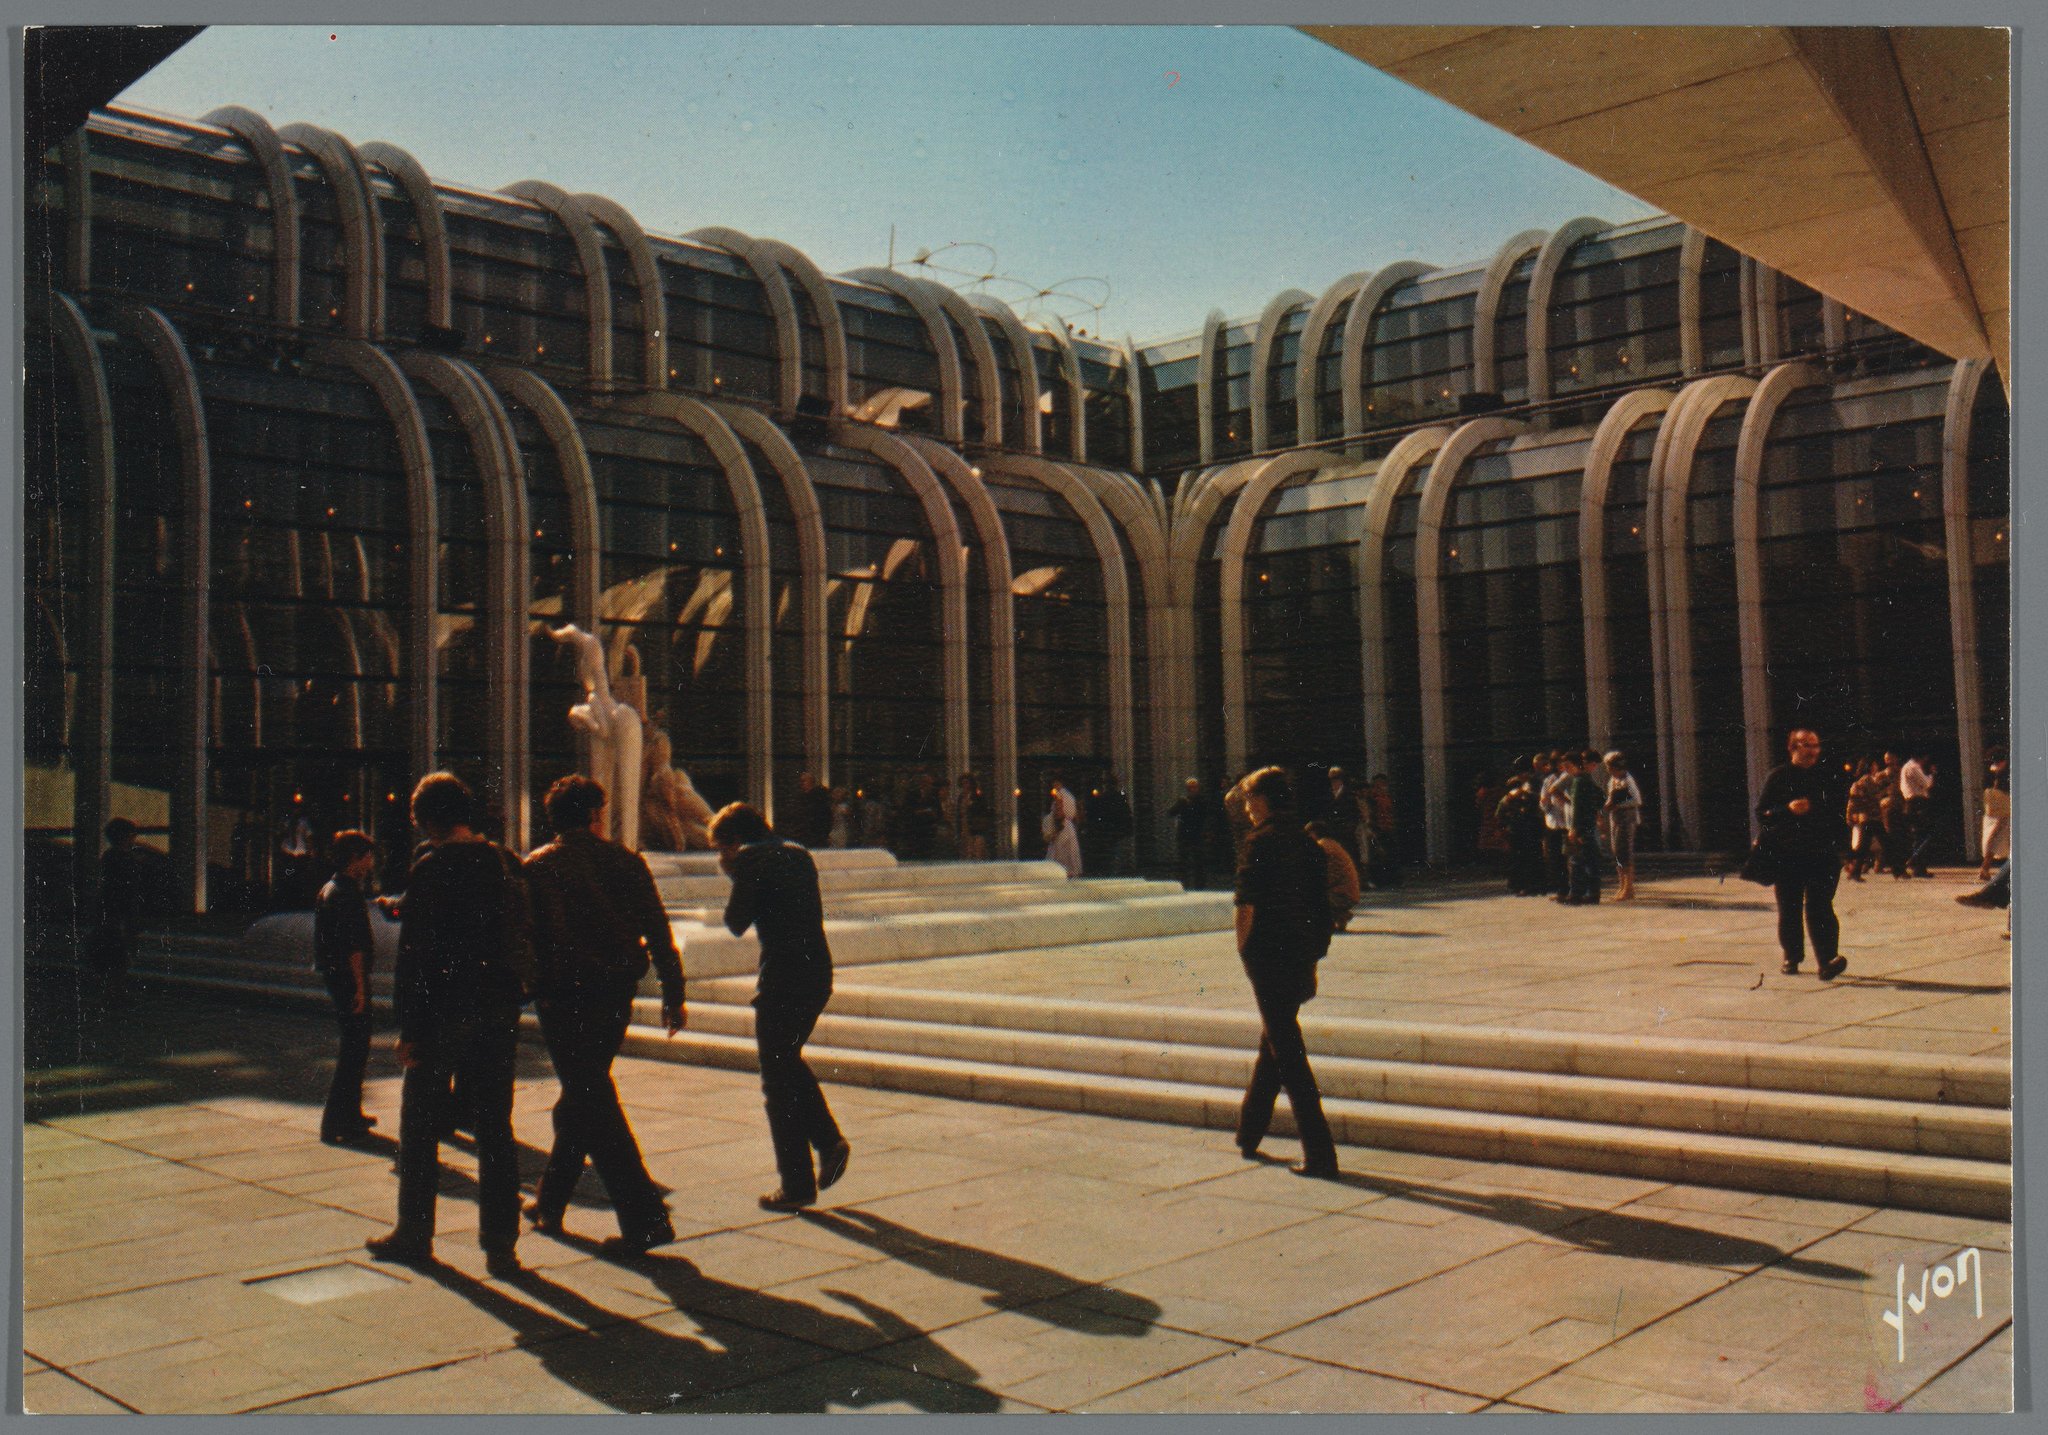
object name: postcard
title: Paris. Forum des Halles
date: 1920-1950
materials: photographic support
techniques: rotogravure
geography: paris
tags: paris